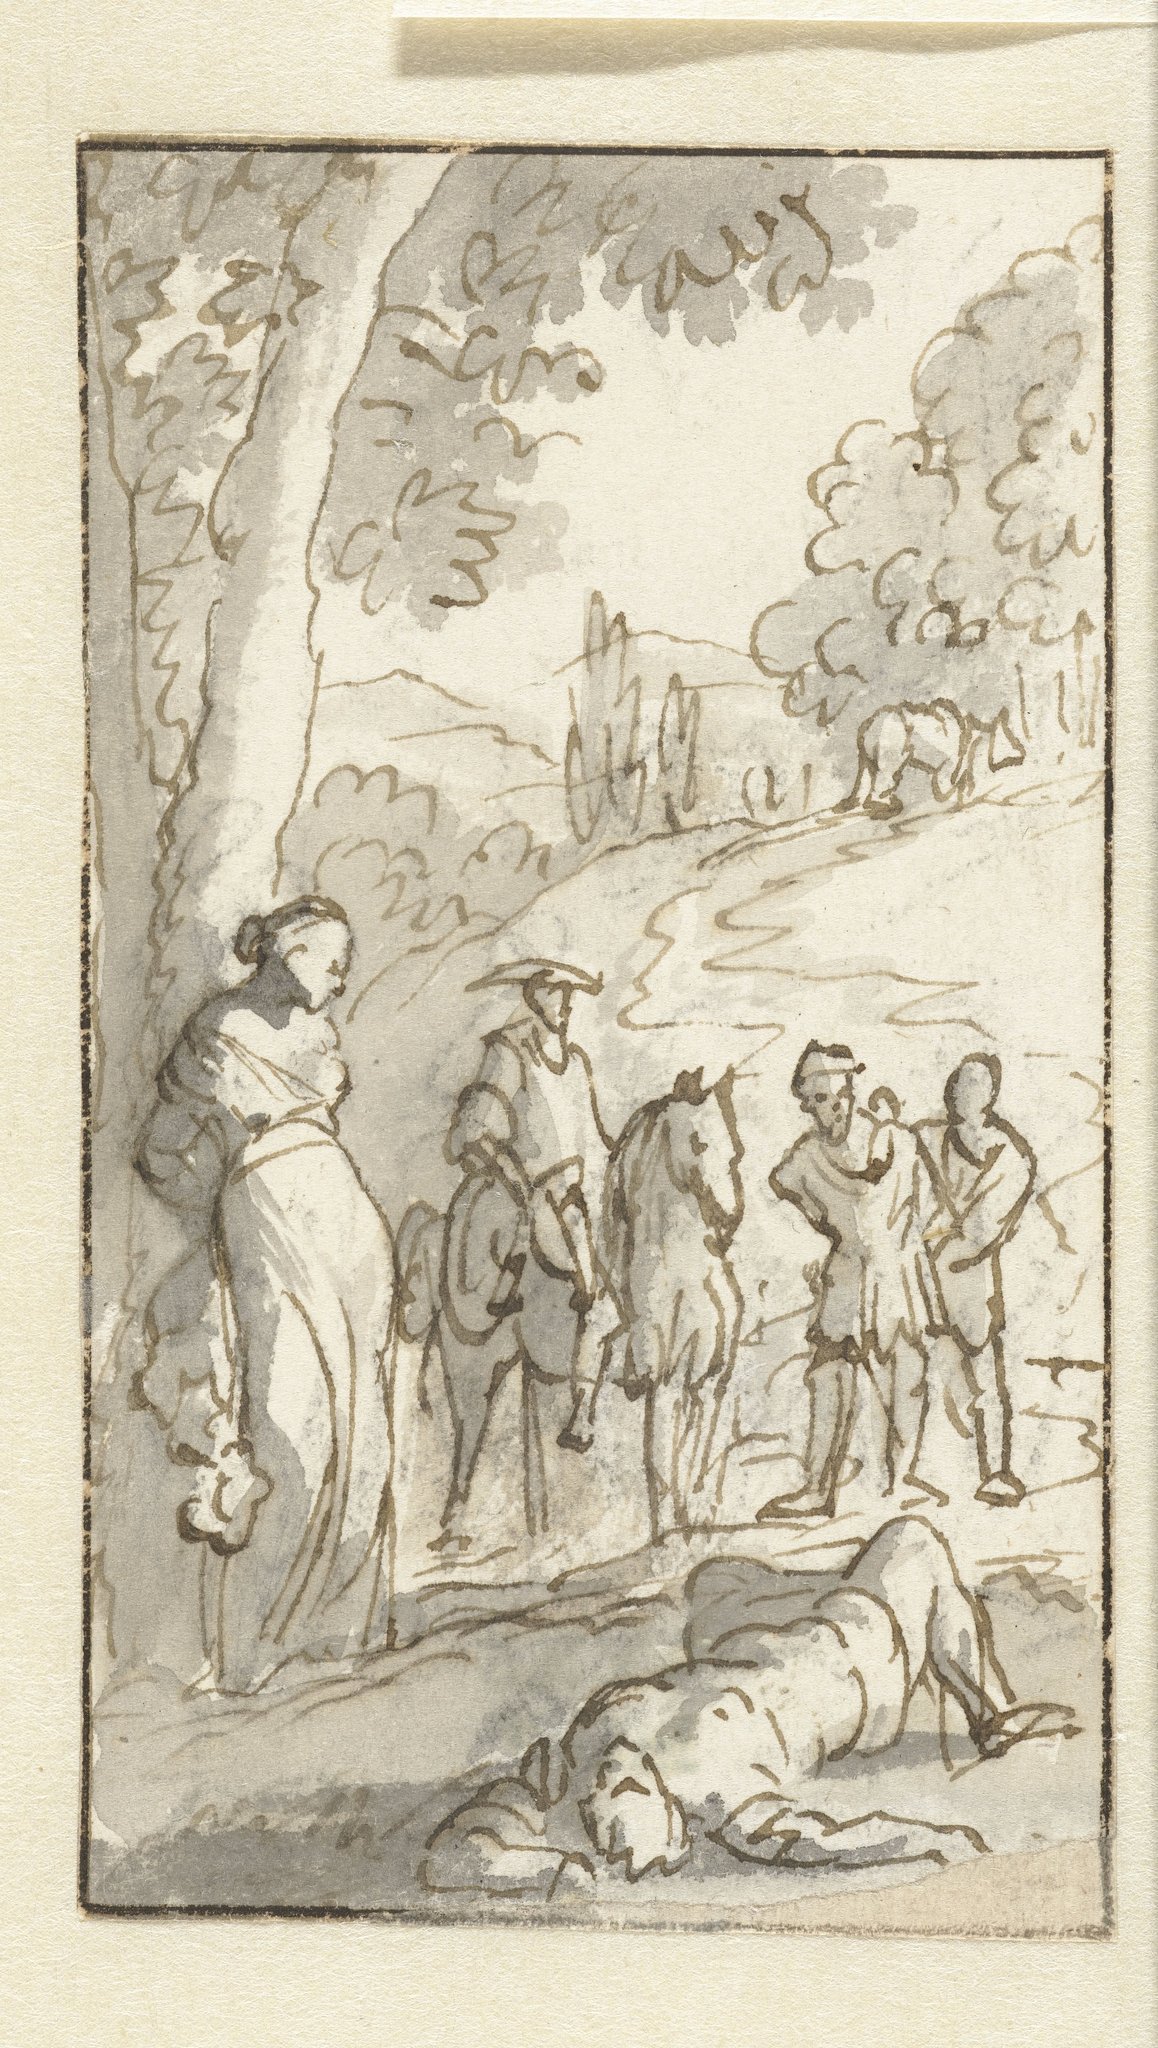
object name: drawing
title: Ontwerpen voor het vijfde deel van Histoire de l'admirable Don Quixotte (...)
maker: caspar luyken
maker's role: draughtsman, print maker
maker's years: 1672-1708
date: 1694-1696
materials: ink, paper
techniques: brush, pen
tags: don quixote, sancho panza, female literary characters (with name), male literary characters (with name)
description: Ontwerp voor illustratie in het vijfde deel van Cervantes' Histoire de l'admirable Don Quixotte de la Manche.